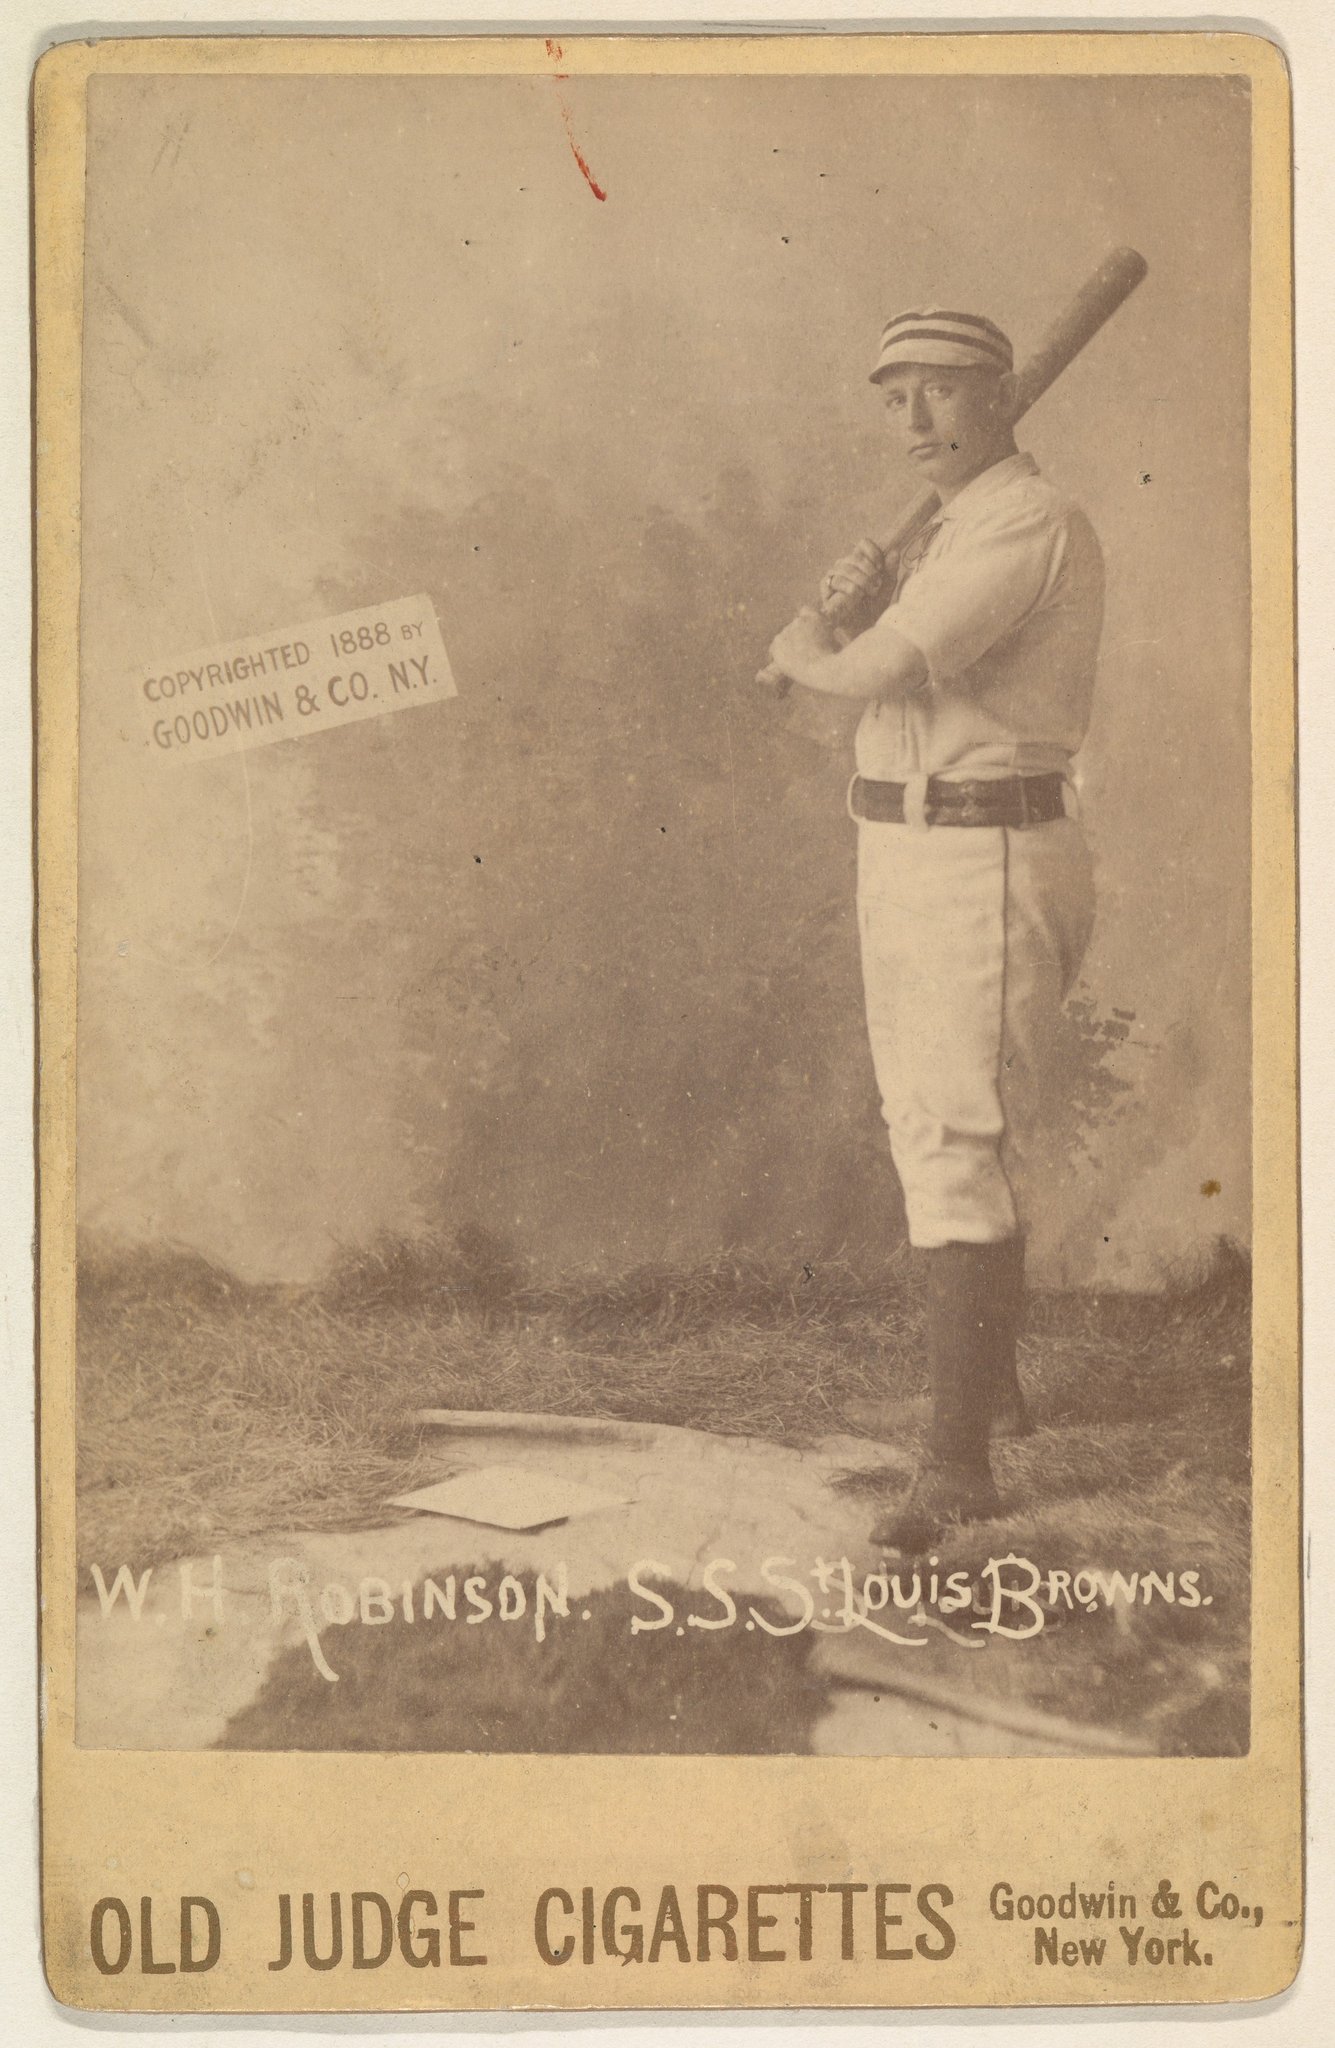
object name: baseball card, photograph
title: W.H. Robinson, Shortstop, St. Louis Browns, from the series Old Judge Cigarettes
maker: goodwin & company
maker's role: publisher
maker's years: 1850-1950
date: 1888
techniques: albumen print, photography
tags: men,portraits,baseball,athletes